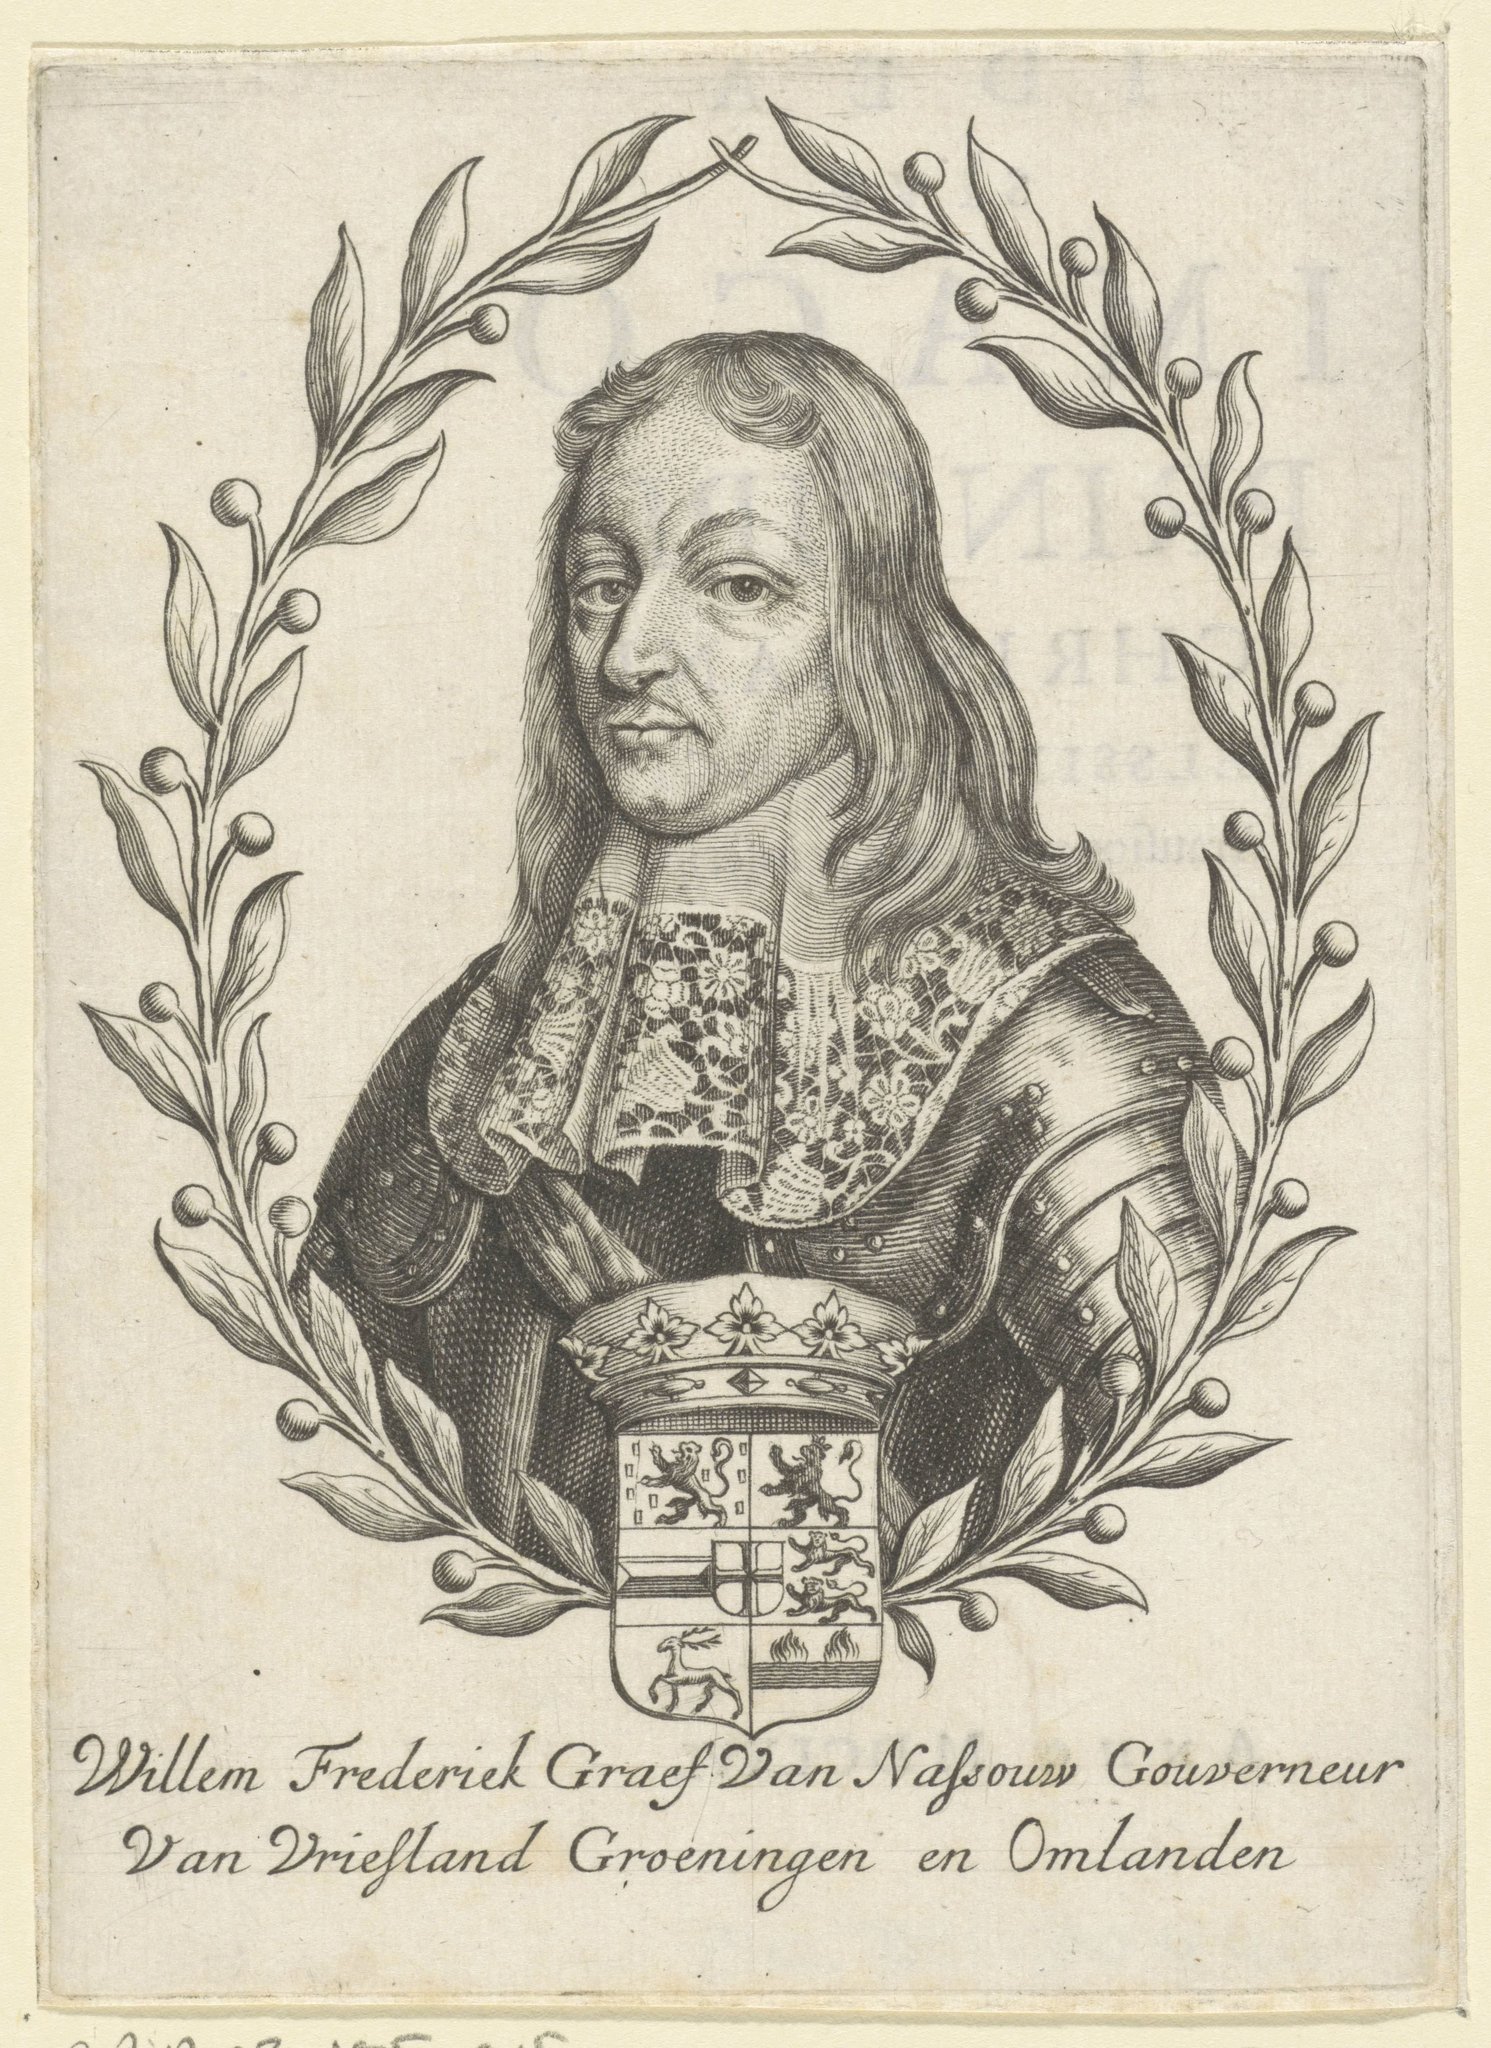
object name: book illustration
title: Portret van Willem Frederik, graaf van Nassau-Dietz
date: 1667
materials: paper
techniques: engraving, etching, letterpress printing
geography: low countries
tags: arnhem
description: De hier vermelde titel verwijst naar de hoogst verkregen titel van de geportretteerde, niet per se naar de titel die de geportretteerde op deze voorstelling draagt. Prent uit: Scriverius, Petrus. Oude en nieuwe beschryvinghe van Holland, Zeeland en Vriesland. Den Haag: Levijn van Dijck, 1667.